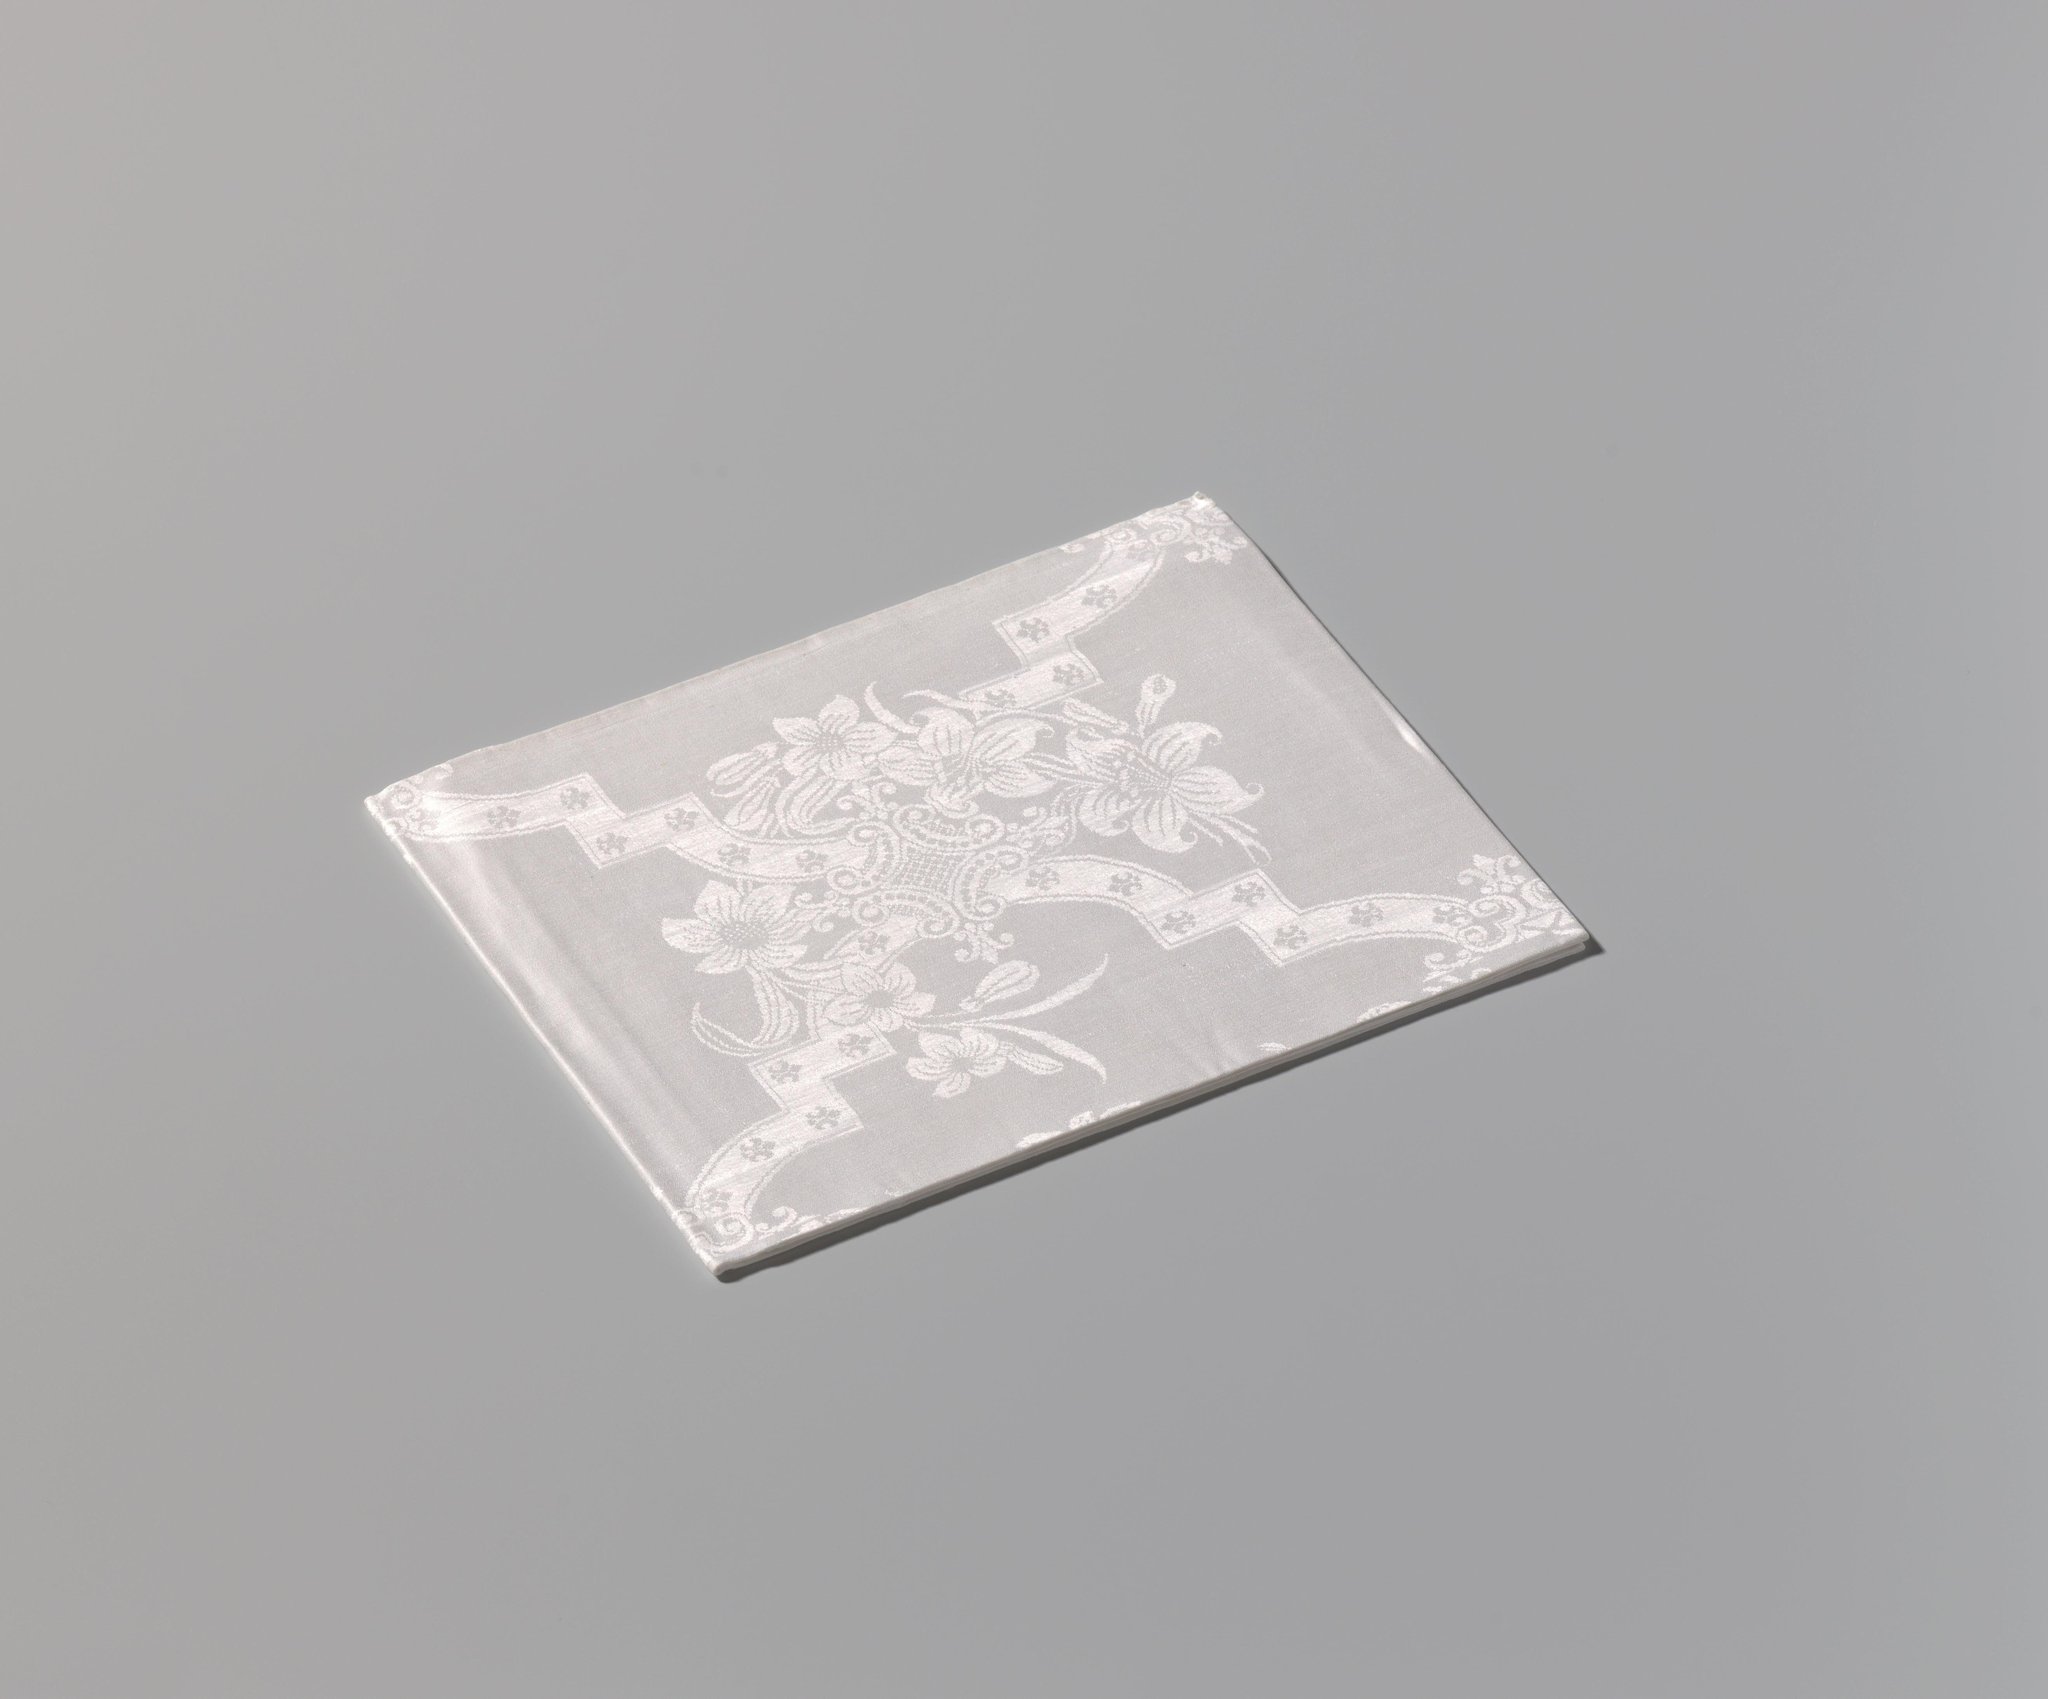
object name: napkin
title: Servet met fleurs de lys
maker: Anonymous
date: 1700-1710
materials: linen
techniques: damask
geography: dresden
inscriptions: mark: ‘24’, mark: ‘BLS’, label: ‘R.M.A'dam’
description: Servet van linnendamast met fleurs de lys. Slingerende banden vormen in de hoogte gerekte velden. De banden bestaan uit rechte en ronde delen, gevuld met kleine fleurs de lys; op de raakpunten een slingerende tak met leliën. De rand, alleen aan de buitenzijde omlijnd met fijne zigzagzomen en rolwerk met rastervulling, vertoont dicht aaneengesloten bloemboeketten, in de hoeken naar het midden gericht en voortkomend uit een draagstuk, waarop een fleur de lys. Rondom: blokkenrand.